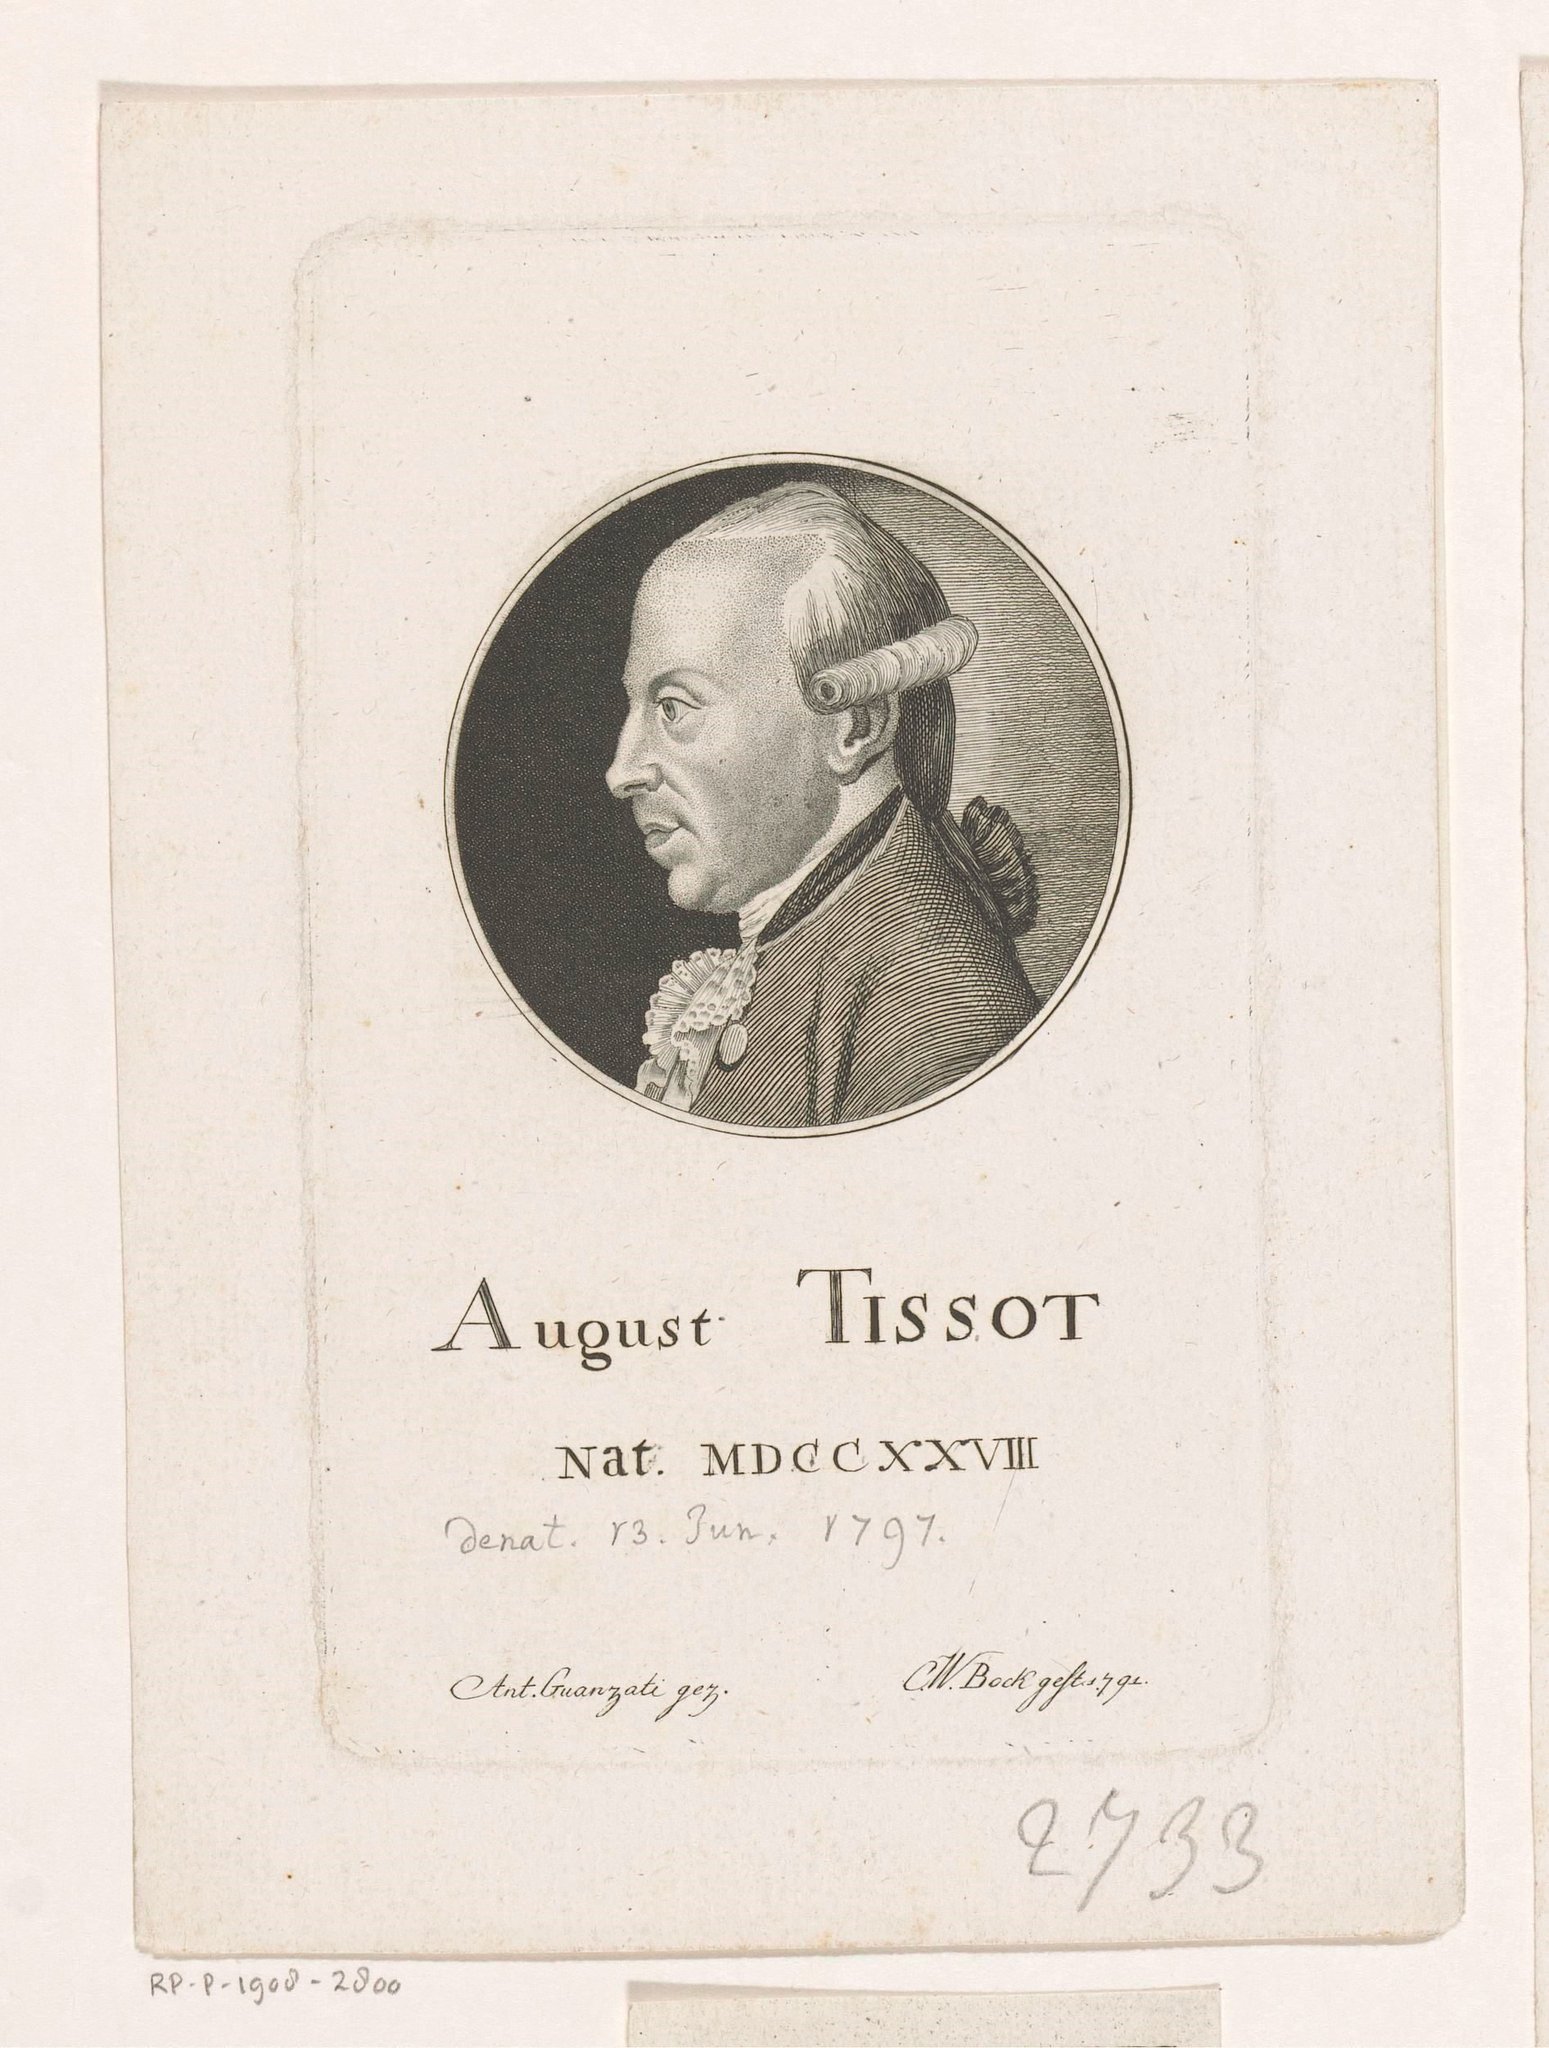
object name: print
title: Portret van Simon Auguste André David Tissot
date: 1791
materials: paper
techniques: engraving, etching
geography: nuremberg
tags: historical persons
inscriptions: collector's mark: Lugt 2228